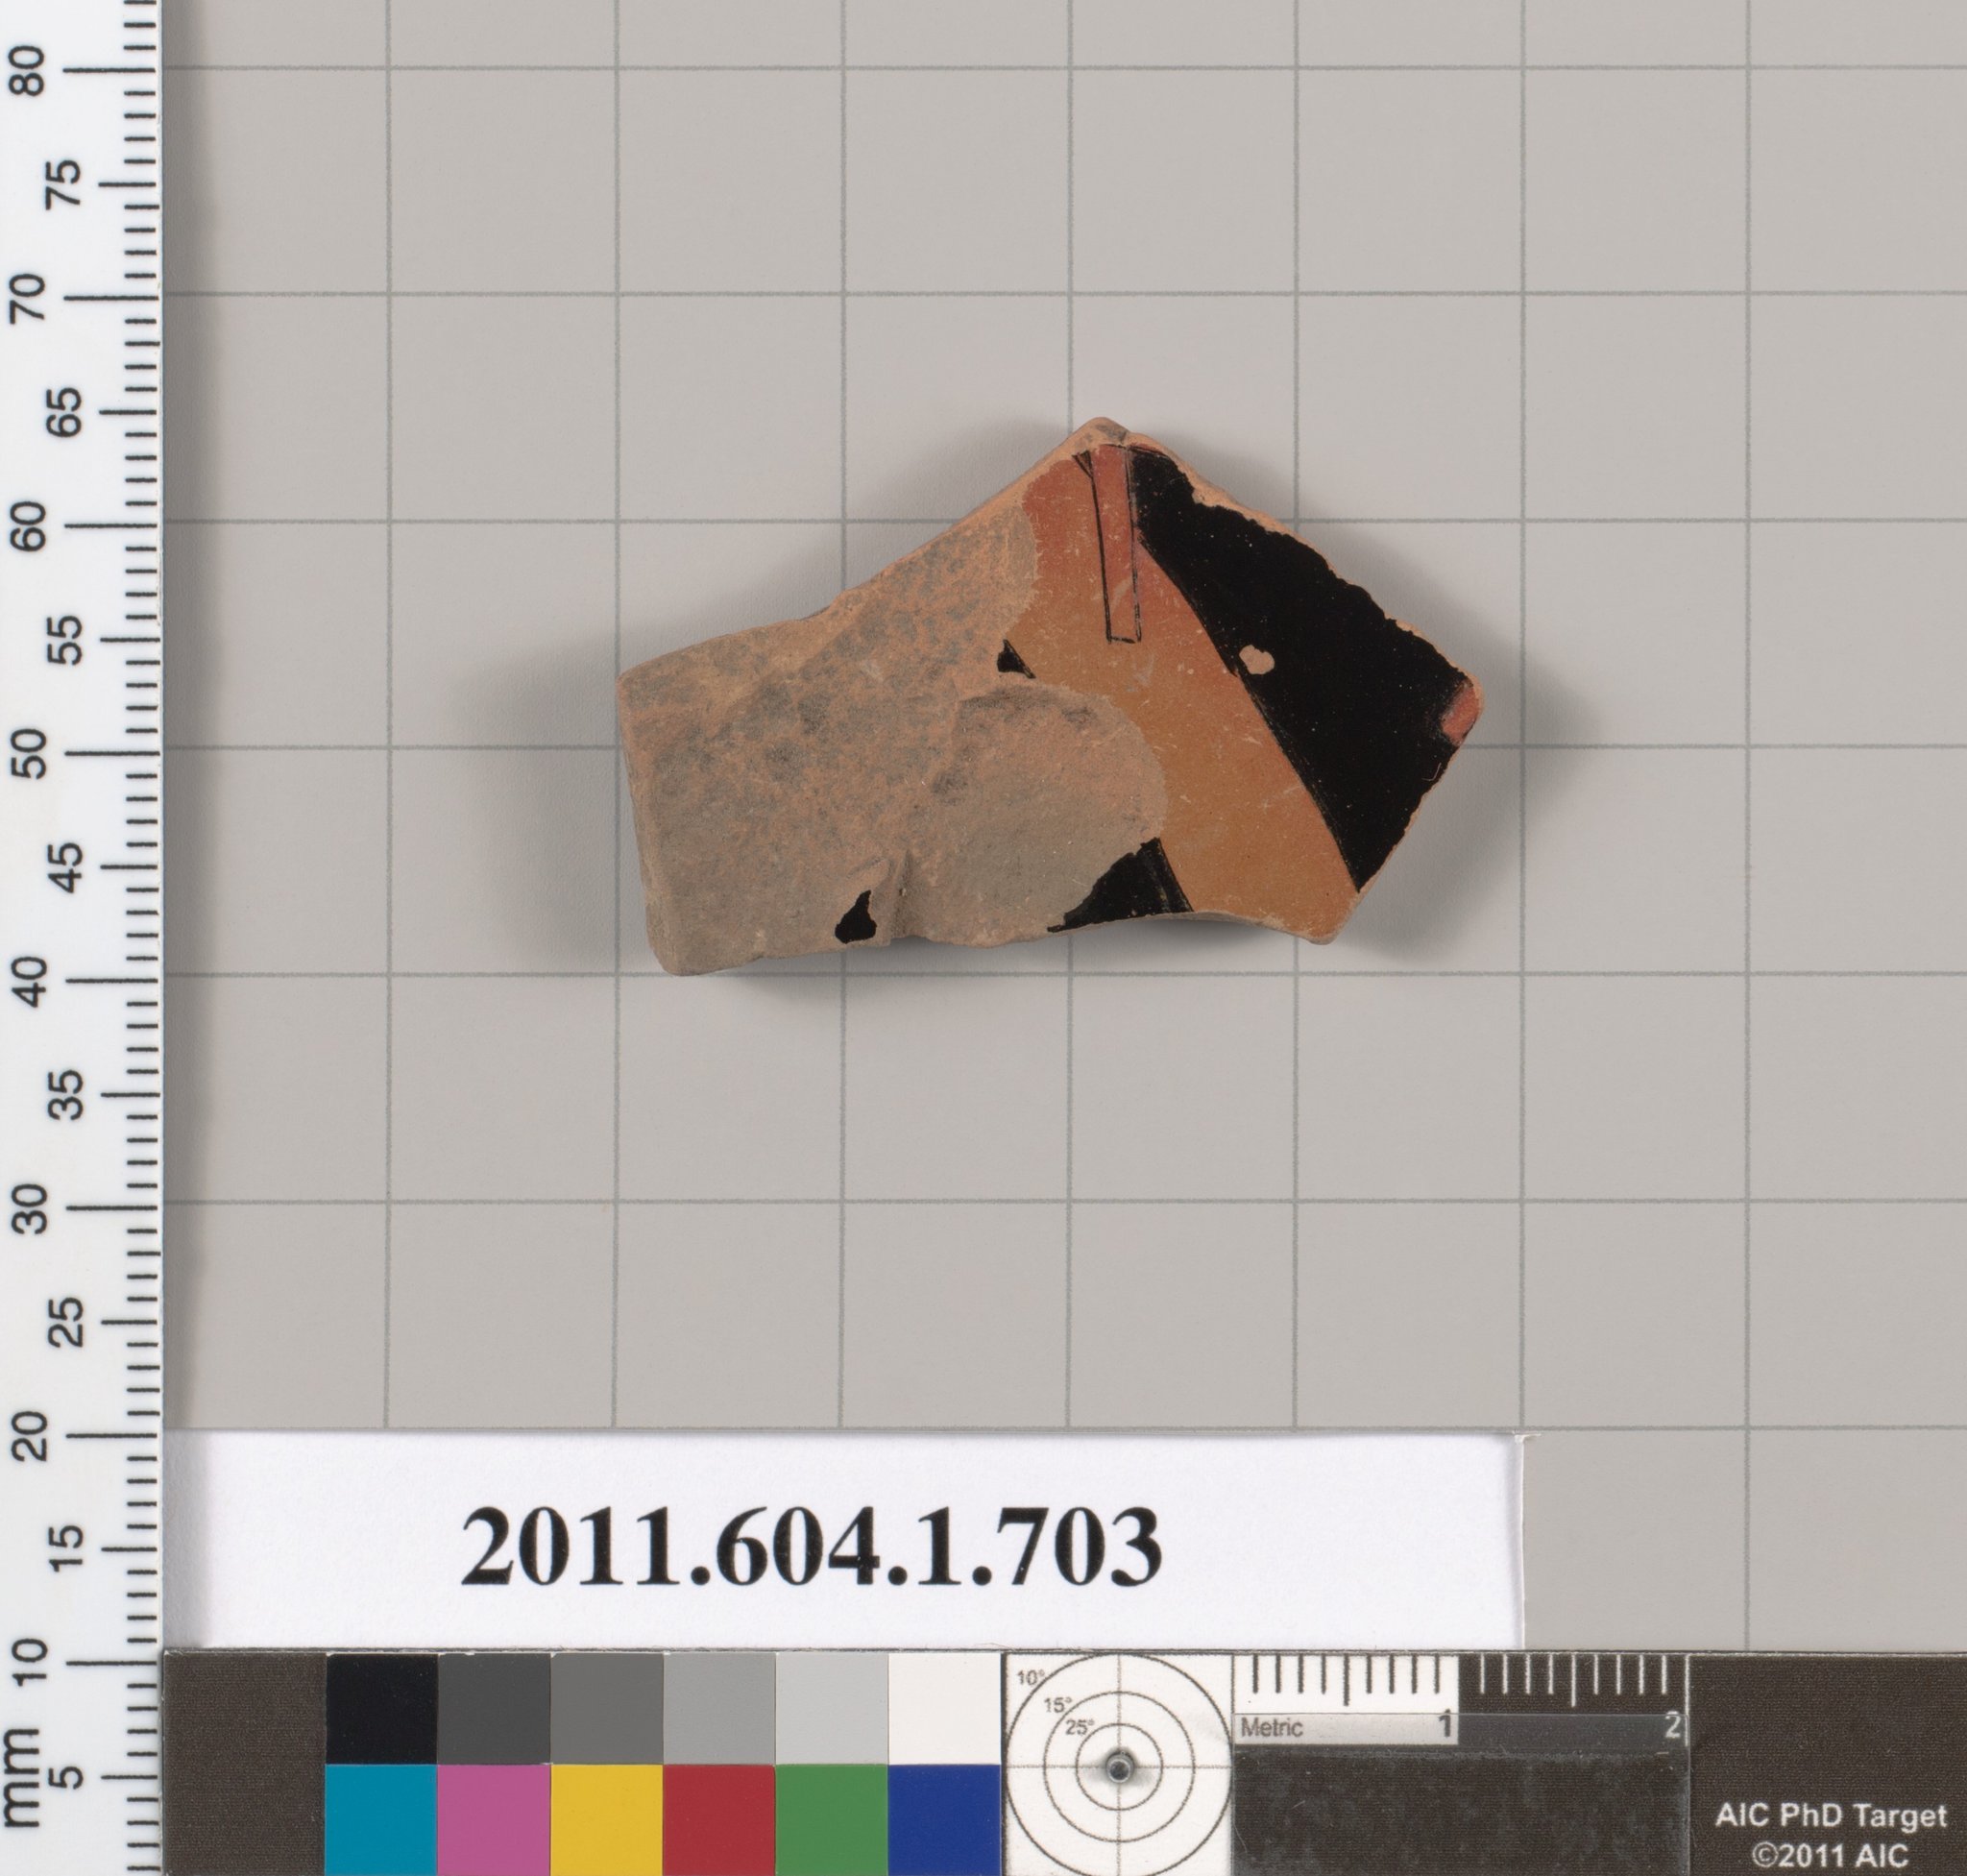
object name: kylix fragment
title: Terracotta fragment of a kylix (drinking cup)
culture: greek, attic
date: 475-451 BCE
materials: terracotta